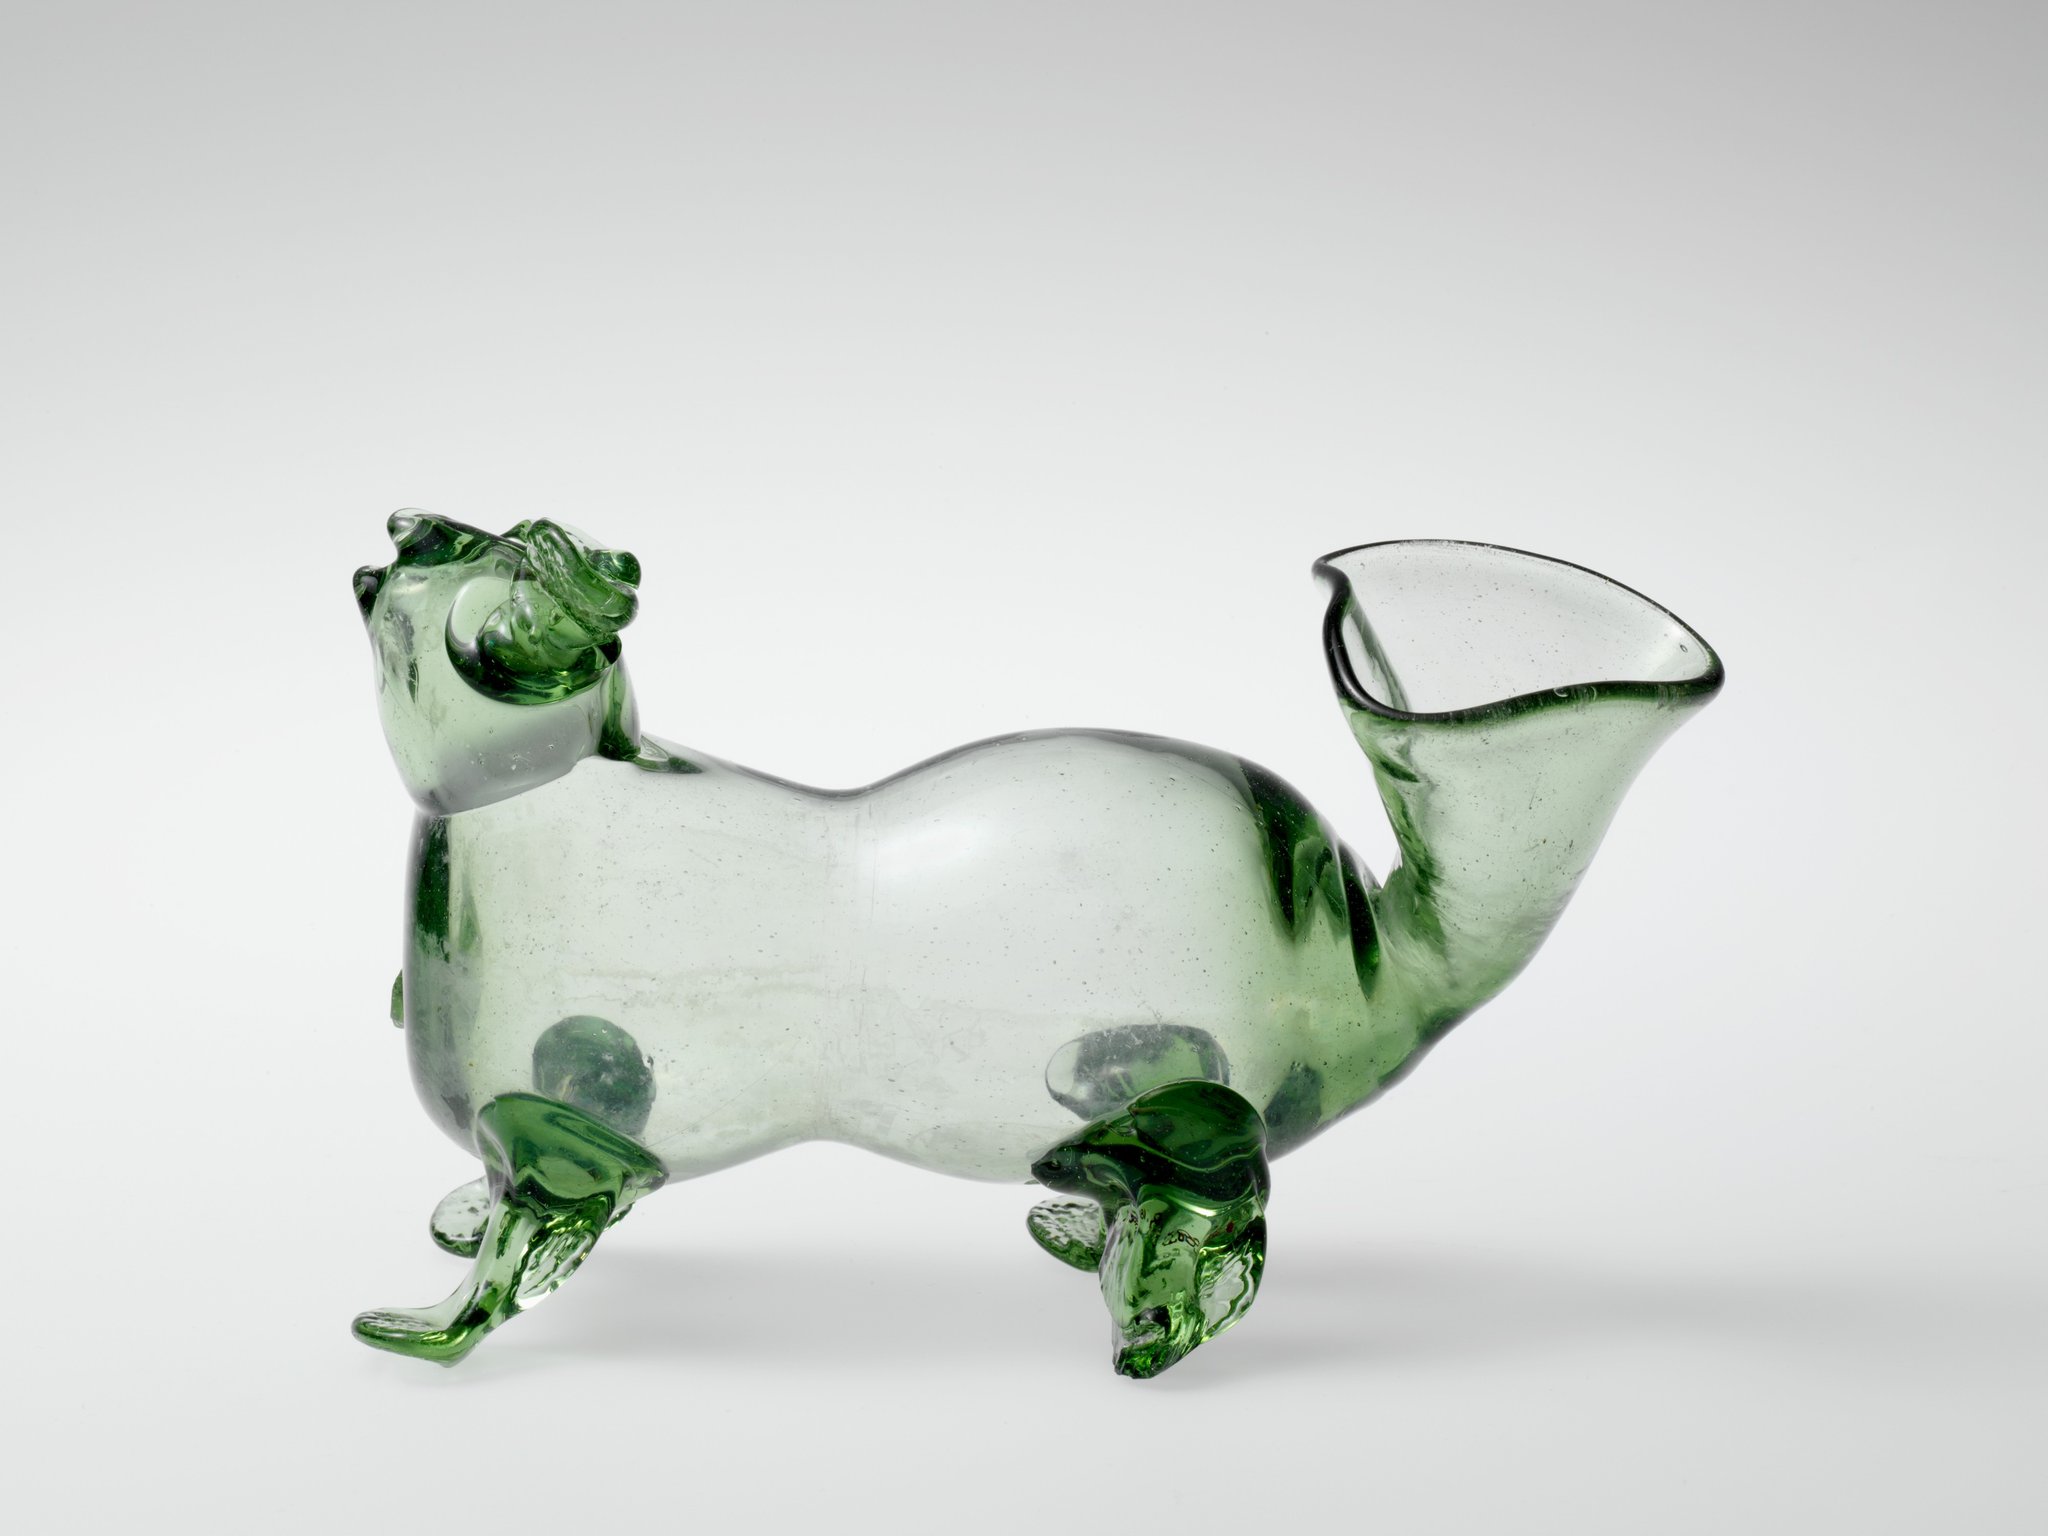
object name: bottle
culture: american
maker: wistarburgh glassworks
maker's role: maker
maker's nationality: american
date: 1738-1777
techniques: glassblowing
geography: united states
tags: dogs